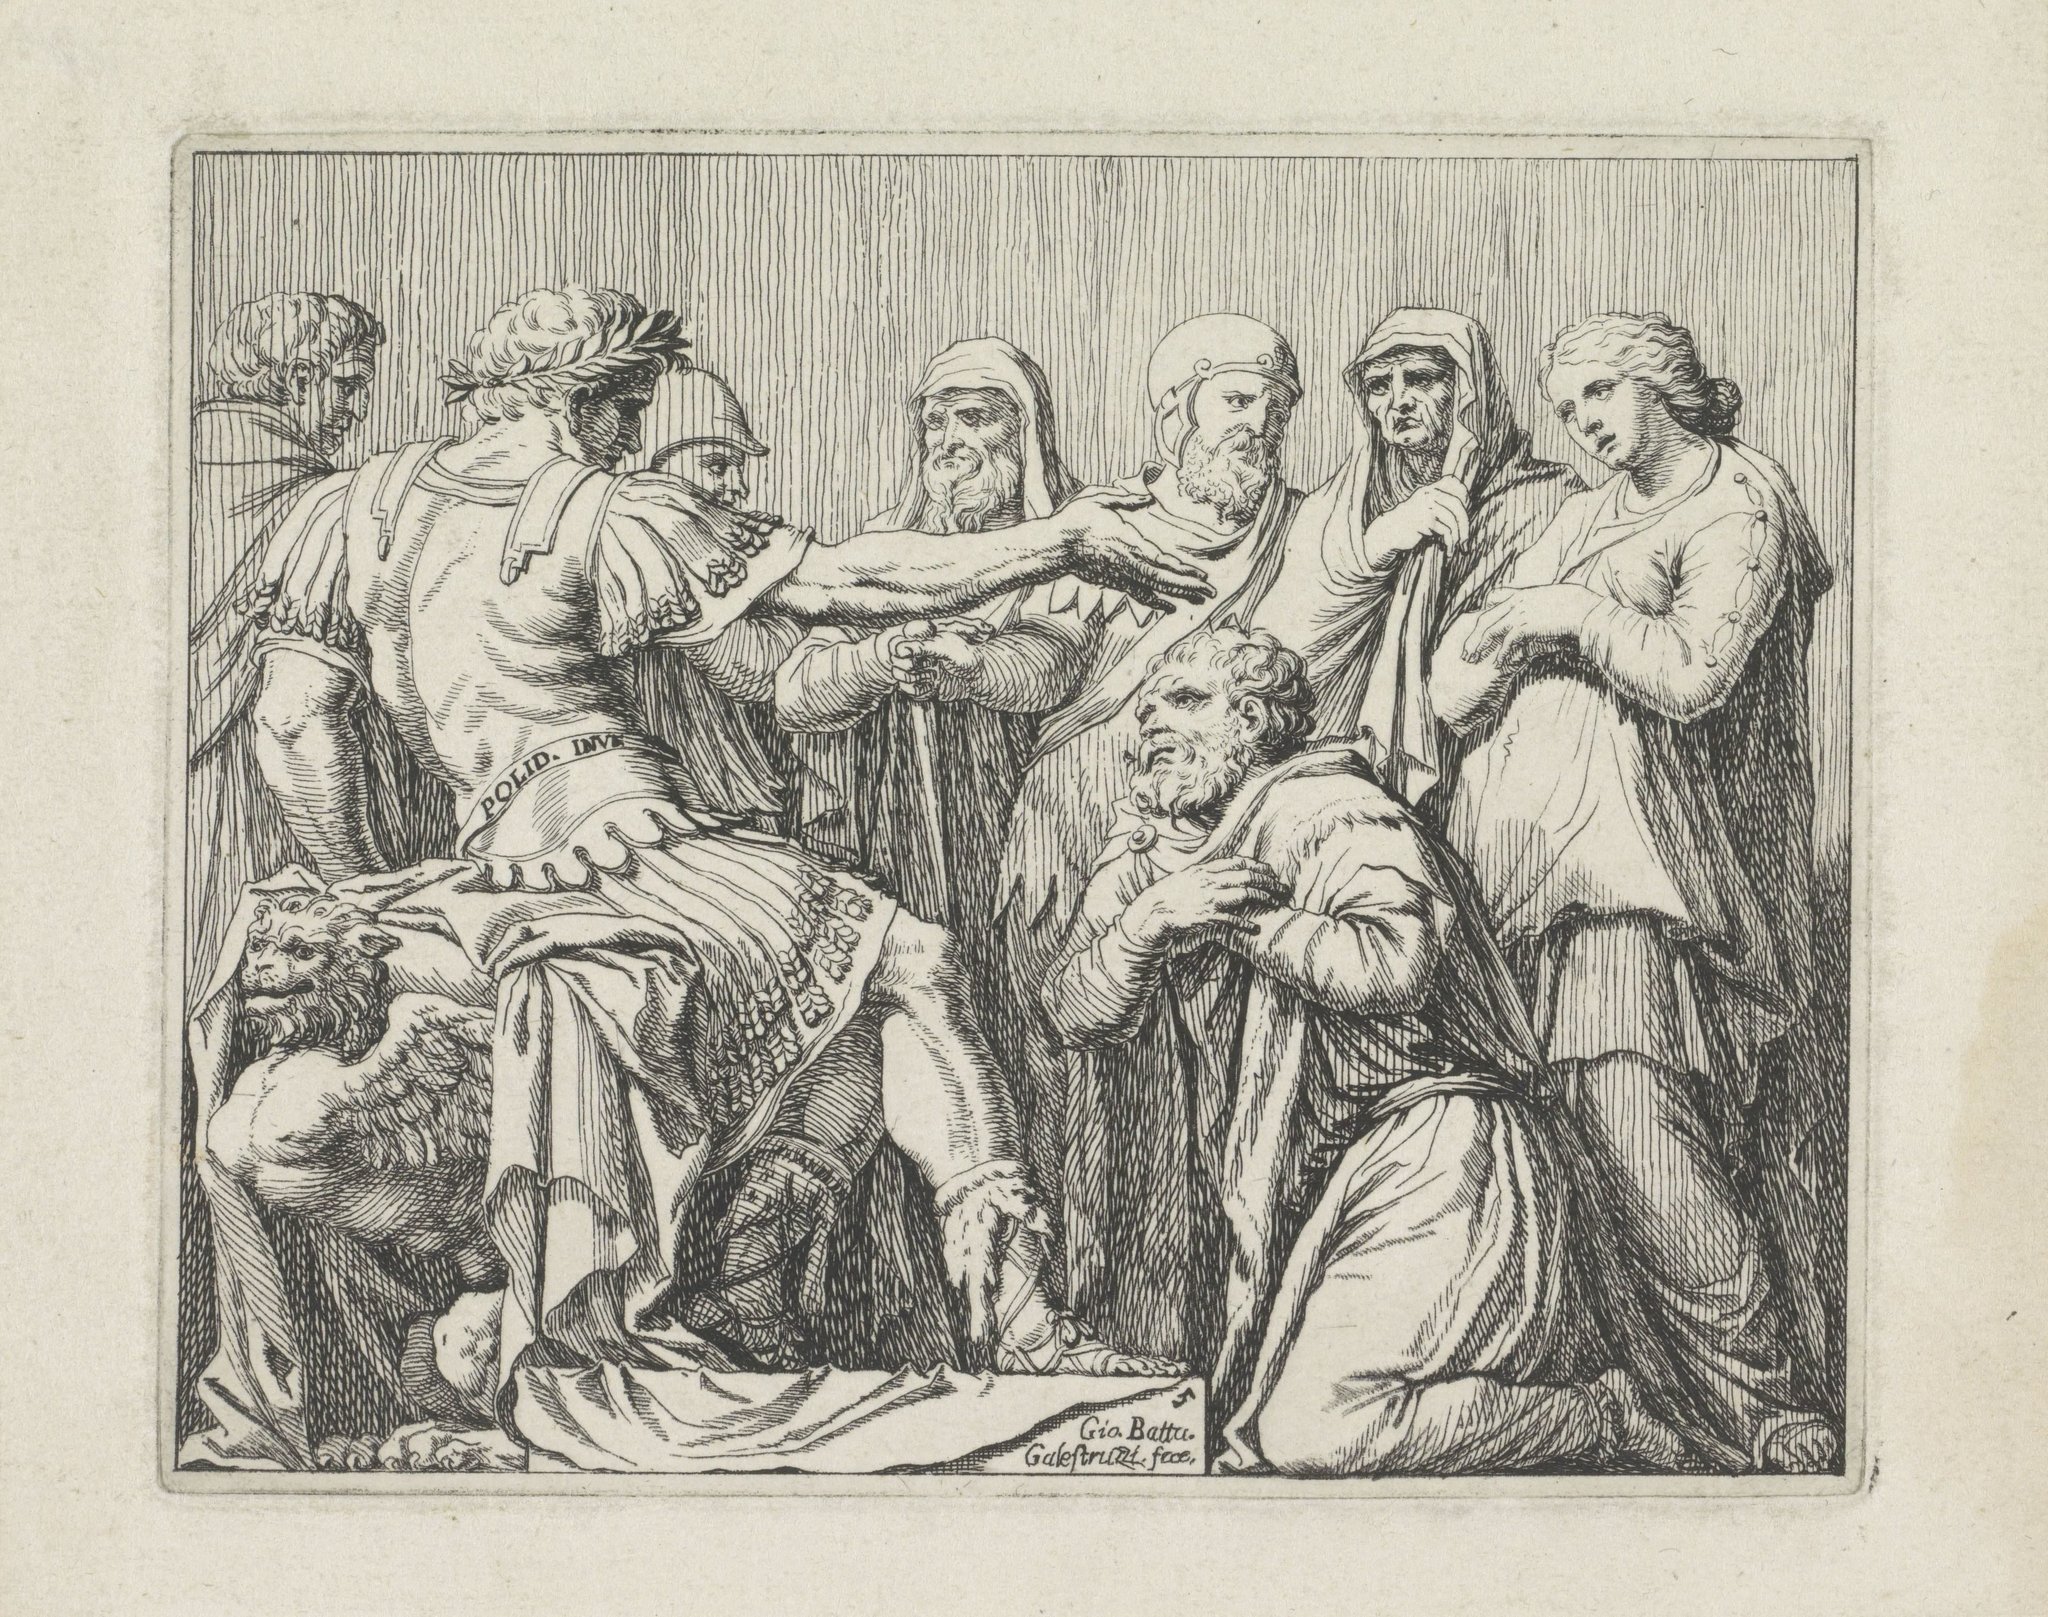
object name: print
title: Scènes uit de Romeinse geschiedenis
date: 1625-1669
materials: paper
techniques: etching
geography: rome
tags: darius' family kneels before alexander, who requests sisigambis, darius' mother, to rise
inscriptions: collector's mark: Lugt 240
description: De originele koperplaat bevindt zich in de Calcografia Nazionale te Rome. Deze prent maakt deel uit van een reeks van zes prenten met scènes uit de Romeinse geschiedenis naar een fresco door Polidoro da Caravaggio op de façade van Palazzo Milanesi te Rome.